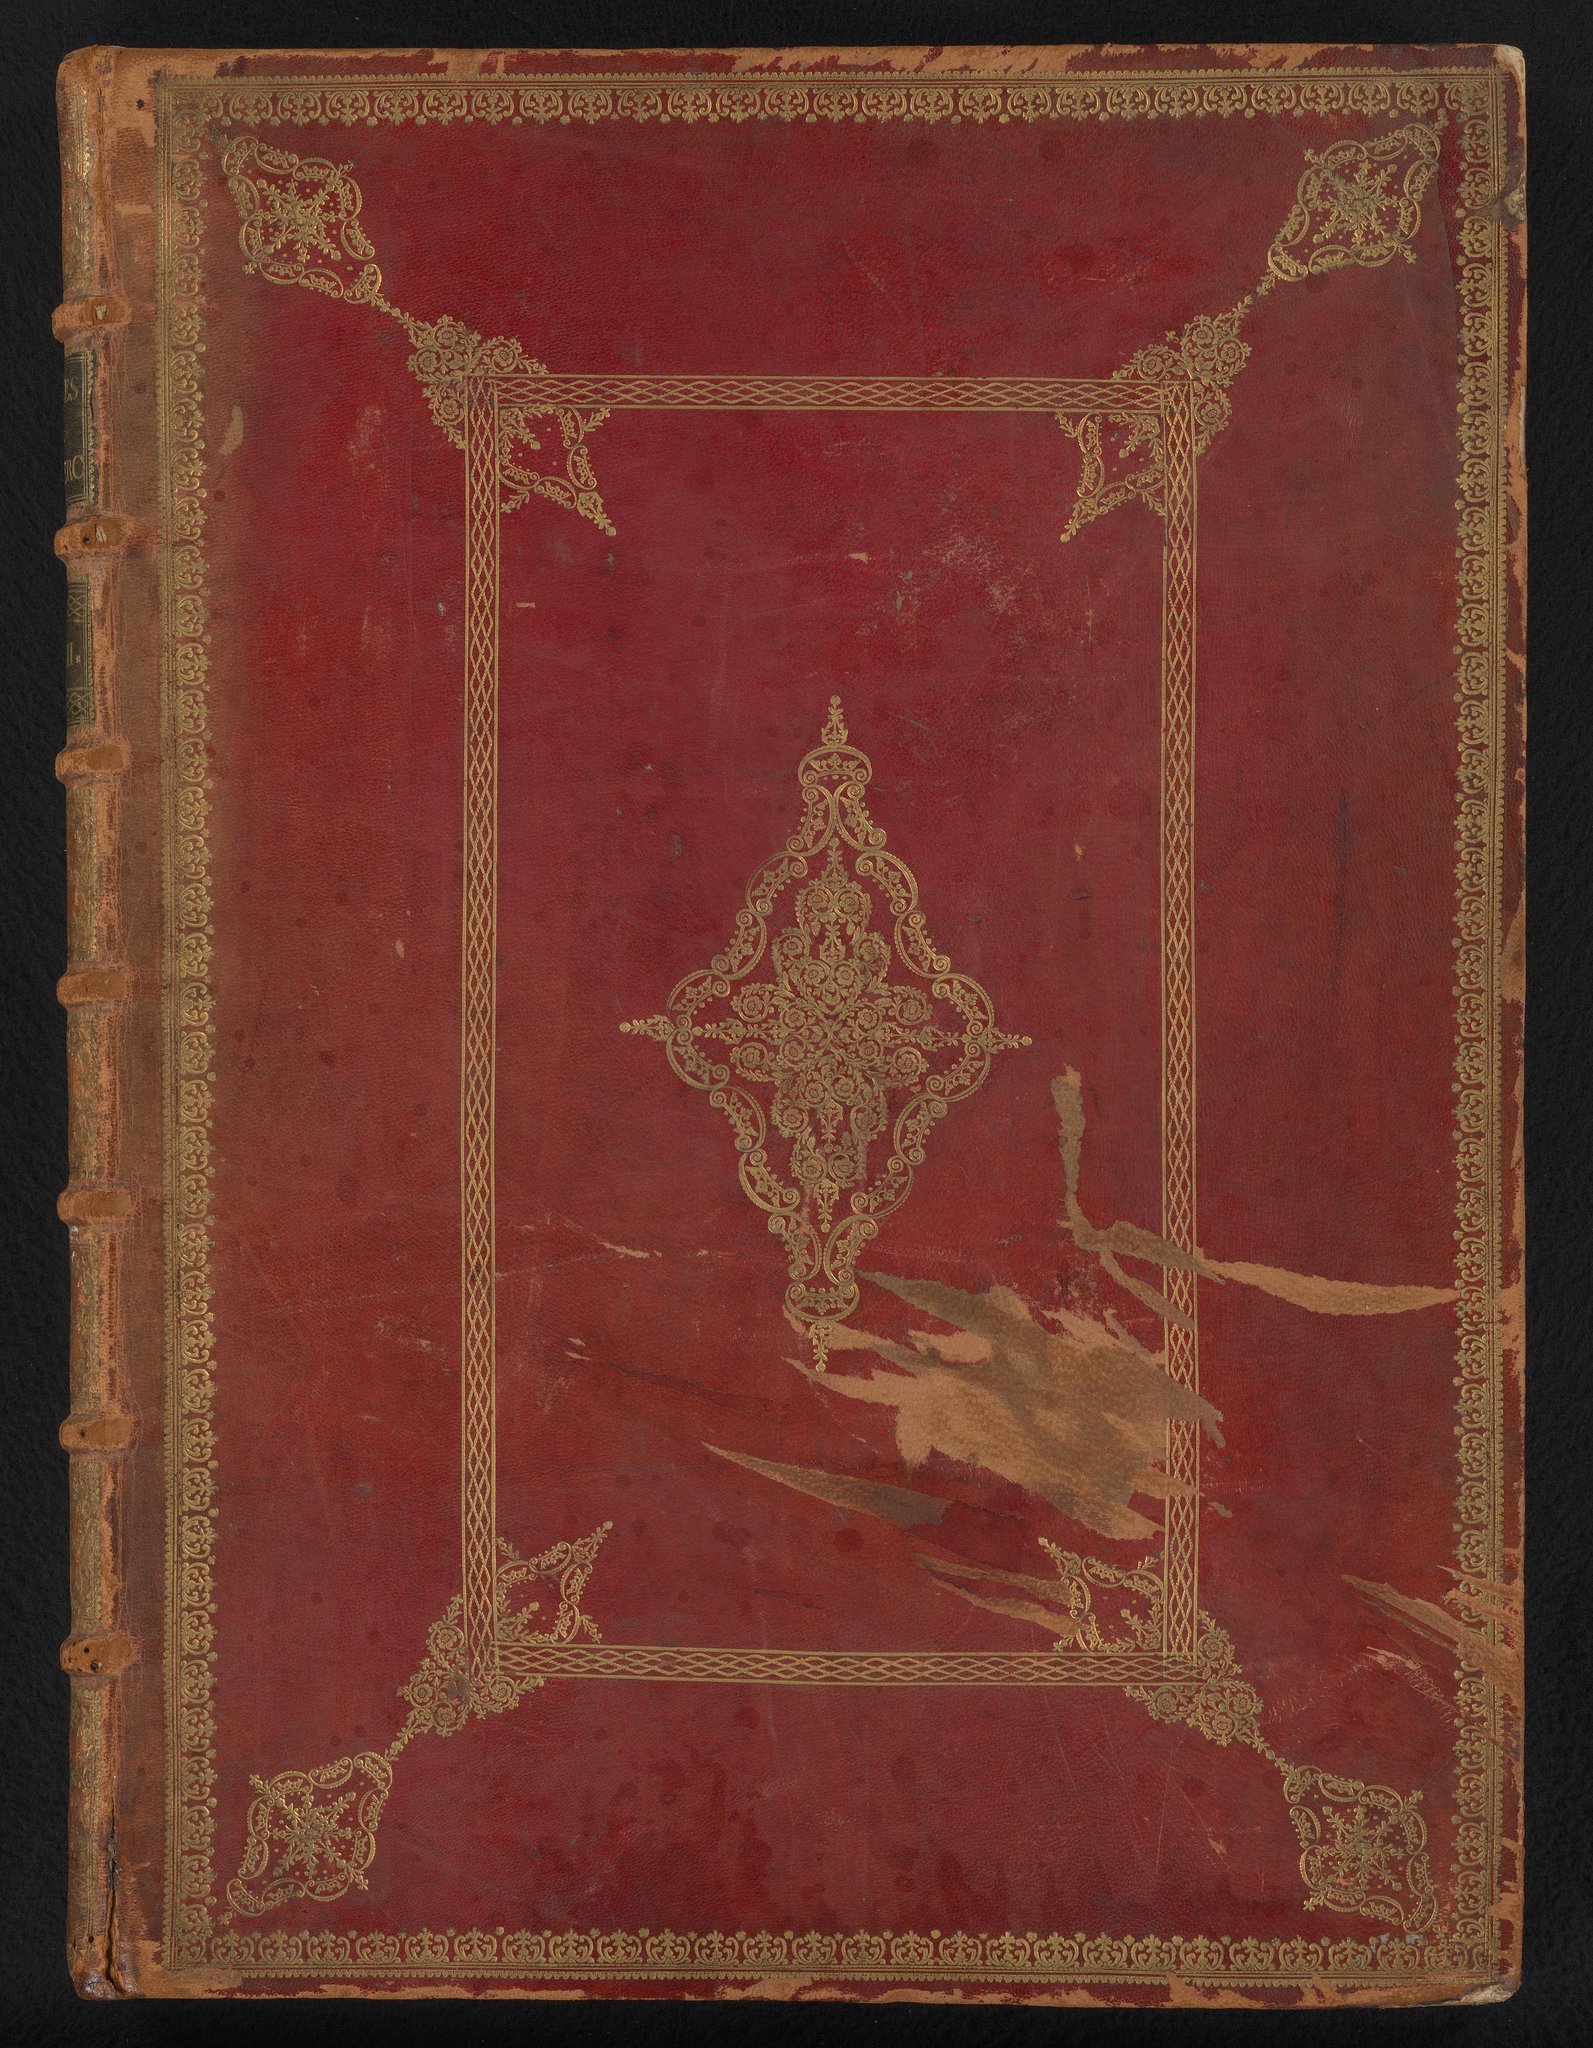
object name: prentrecueil, prentenalbum, prentalbum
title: Oeuvre de Sebastien Le Clerc (...)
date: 1647-1714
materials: cardboard, ink, leather, paper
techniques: bookbinding, engraving, etching, pen, marbled paper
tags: orders, order-books ~ architecture, palace, gravestone, tombstone, fortified city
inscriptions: collector's mark: Lugt 2166, inscription: ‘16/ B.16’, inscription: ‘Ms. Van Leyden 67.4 Tome III/ cat. Bibl. II, 256/7’, collector's mark: Lugt 2165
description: Bladzijde 6 is blanco. Het album is volgens een bepaalde thematische logica samengesteld. Het bevat vooral architectonische voorstellingen, zoals plafonds, triomfbogen en paleizen. Vervolgens bevat het album veel boekillustraties voor publicaties over klassieke architectuur, zoals de werken van Vitruvius. Hier komen ook uitgebreid de verschillende zuilenordes aan bod. Het album eindigt met plattegronden van vestingsteden.